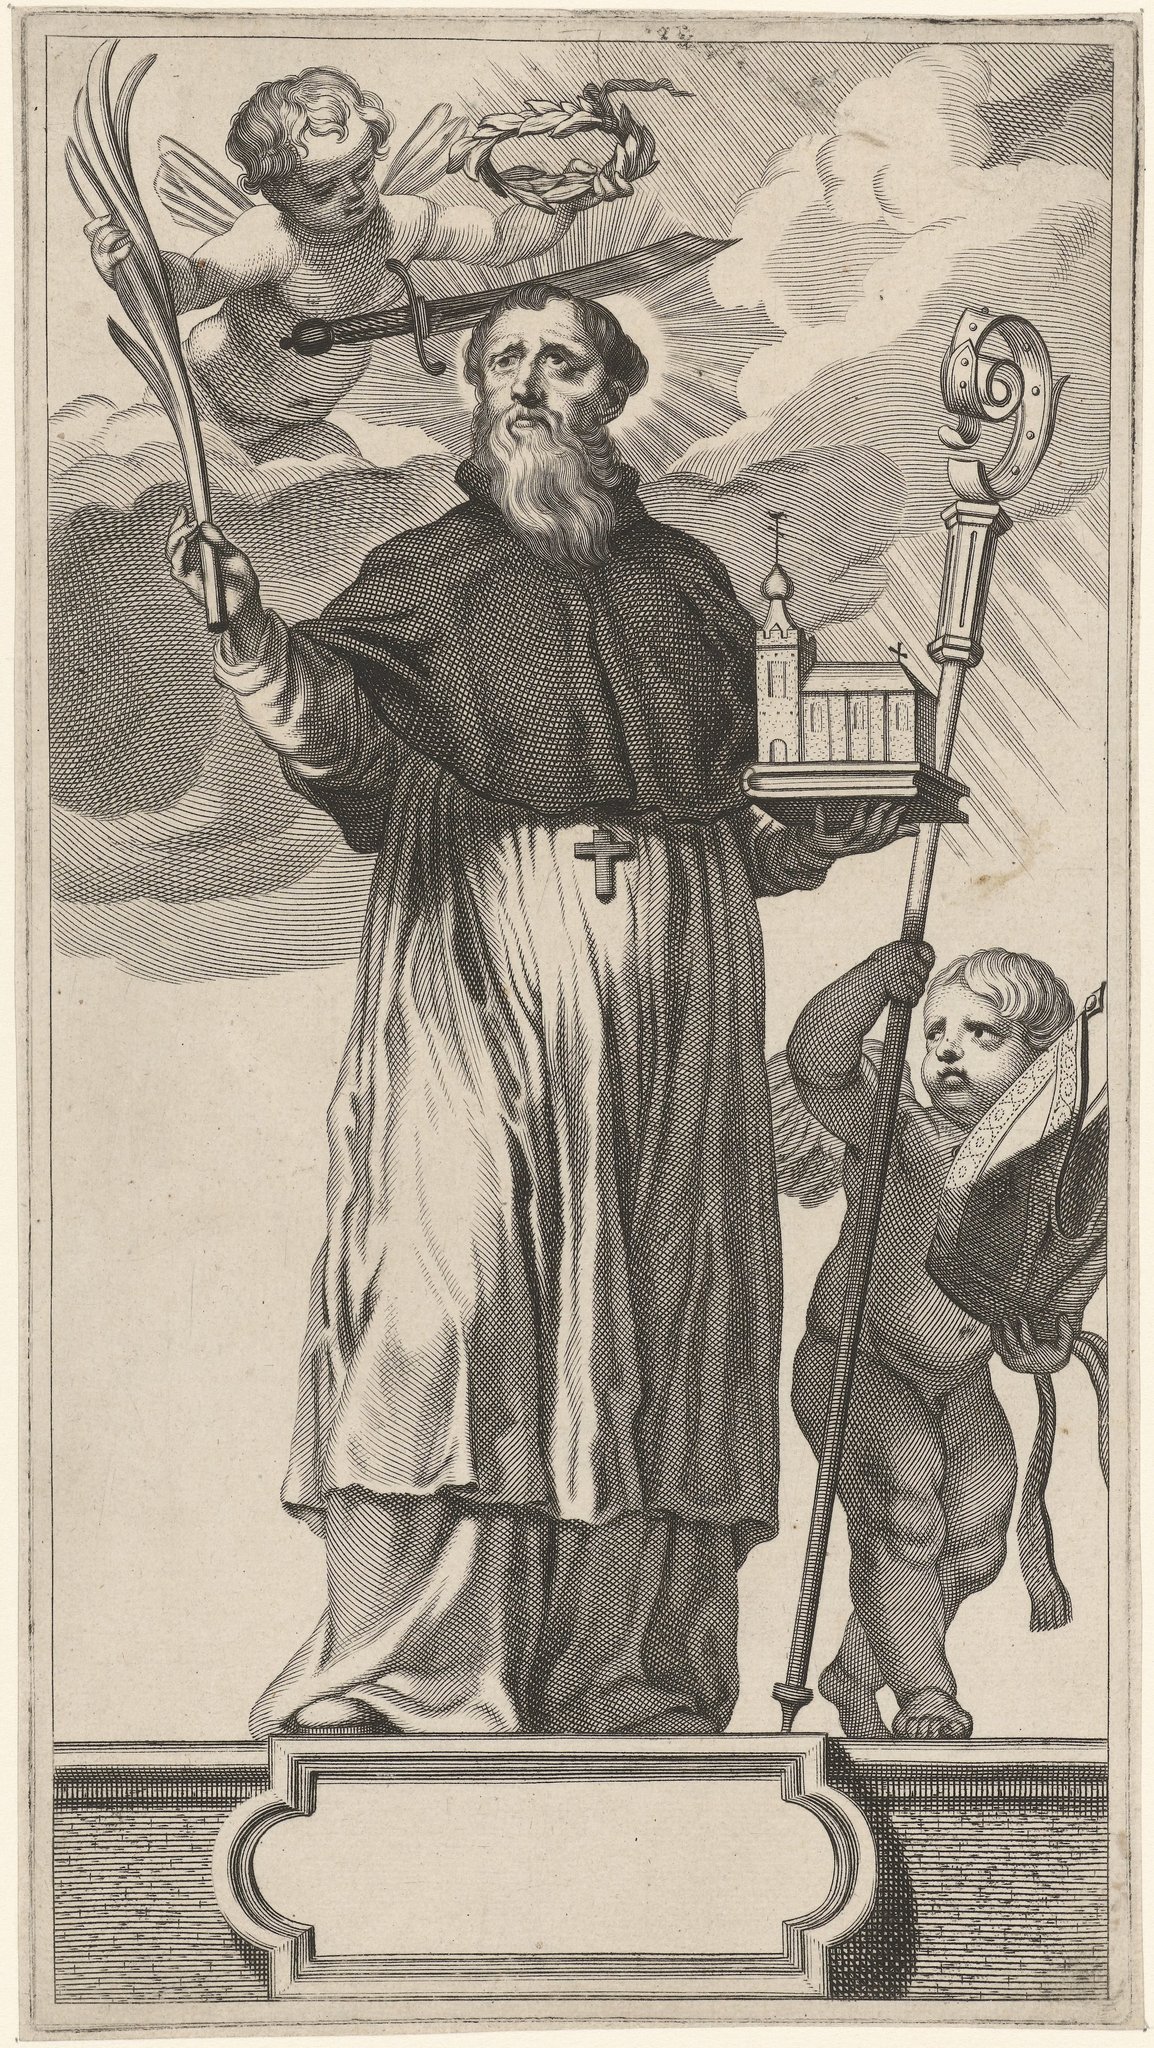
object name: print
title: Heiligen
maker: theodor matham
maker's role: draughtsman, print maker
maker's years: 1605-1676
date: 1615-1676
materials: paper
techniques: engraving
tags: insignia of bishop, e.g. mitre, crozier, crowning with laurel, the martyr thomas becket, archbishop of canterbury; possible attributes: (red) chasuble, sword in skull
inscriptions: collector's mark: Lugt 240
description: De heilige Thomas Becket, met een zwaard in zijn schedel. In zijn hand de kathedraal van Canterbury. Een engel naast hem houdt bisschopmijter en -staf vast. In de lucht een engel met een lauwerkrans. Prent uit een serie van acht prenten met heiligen.